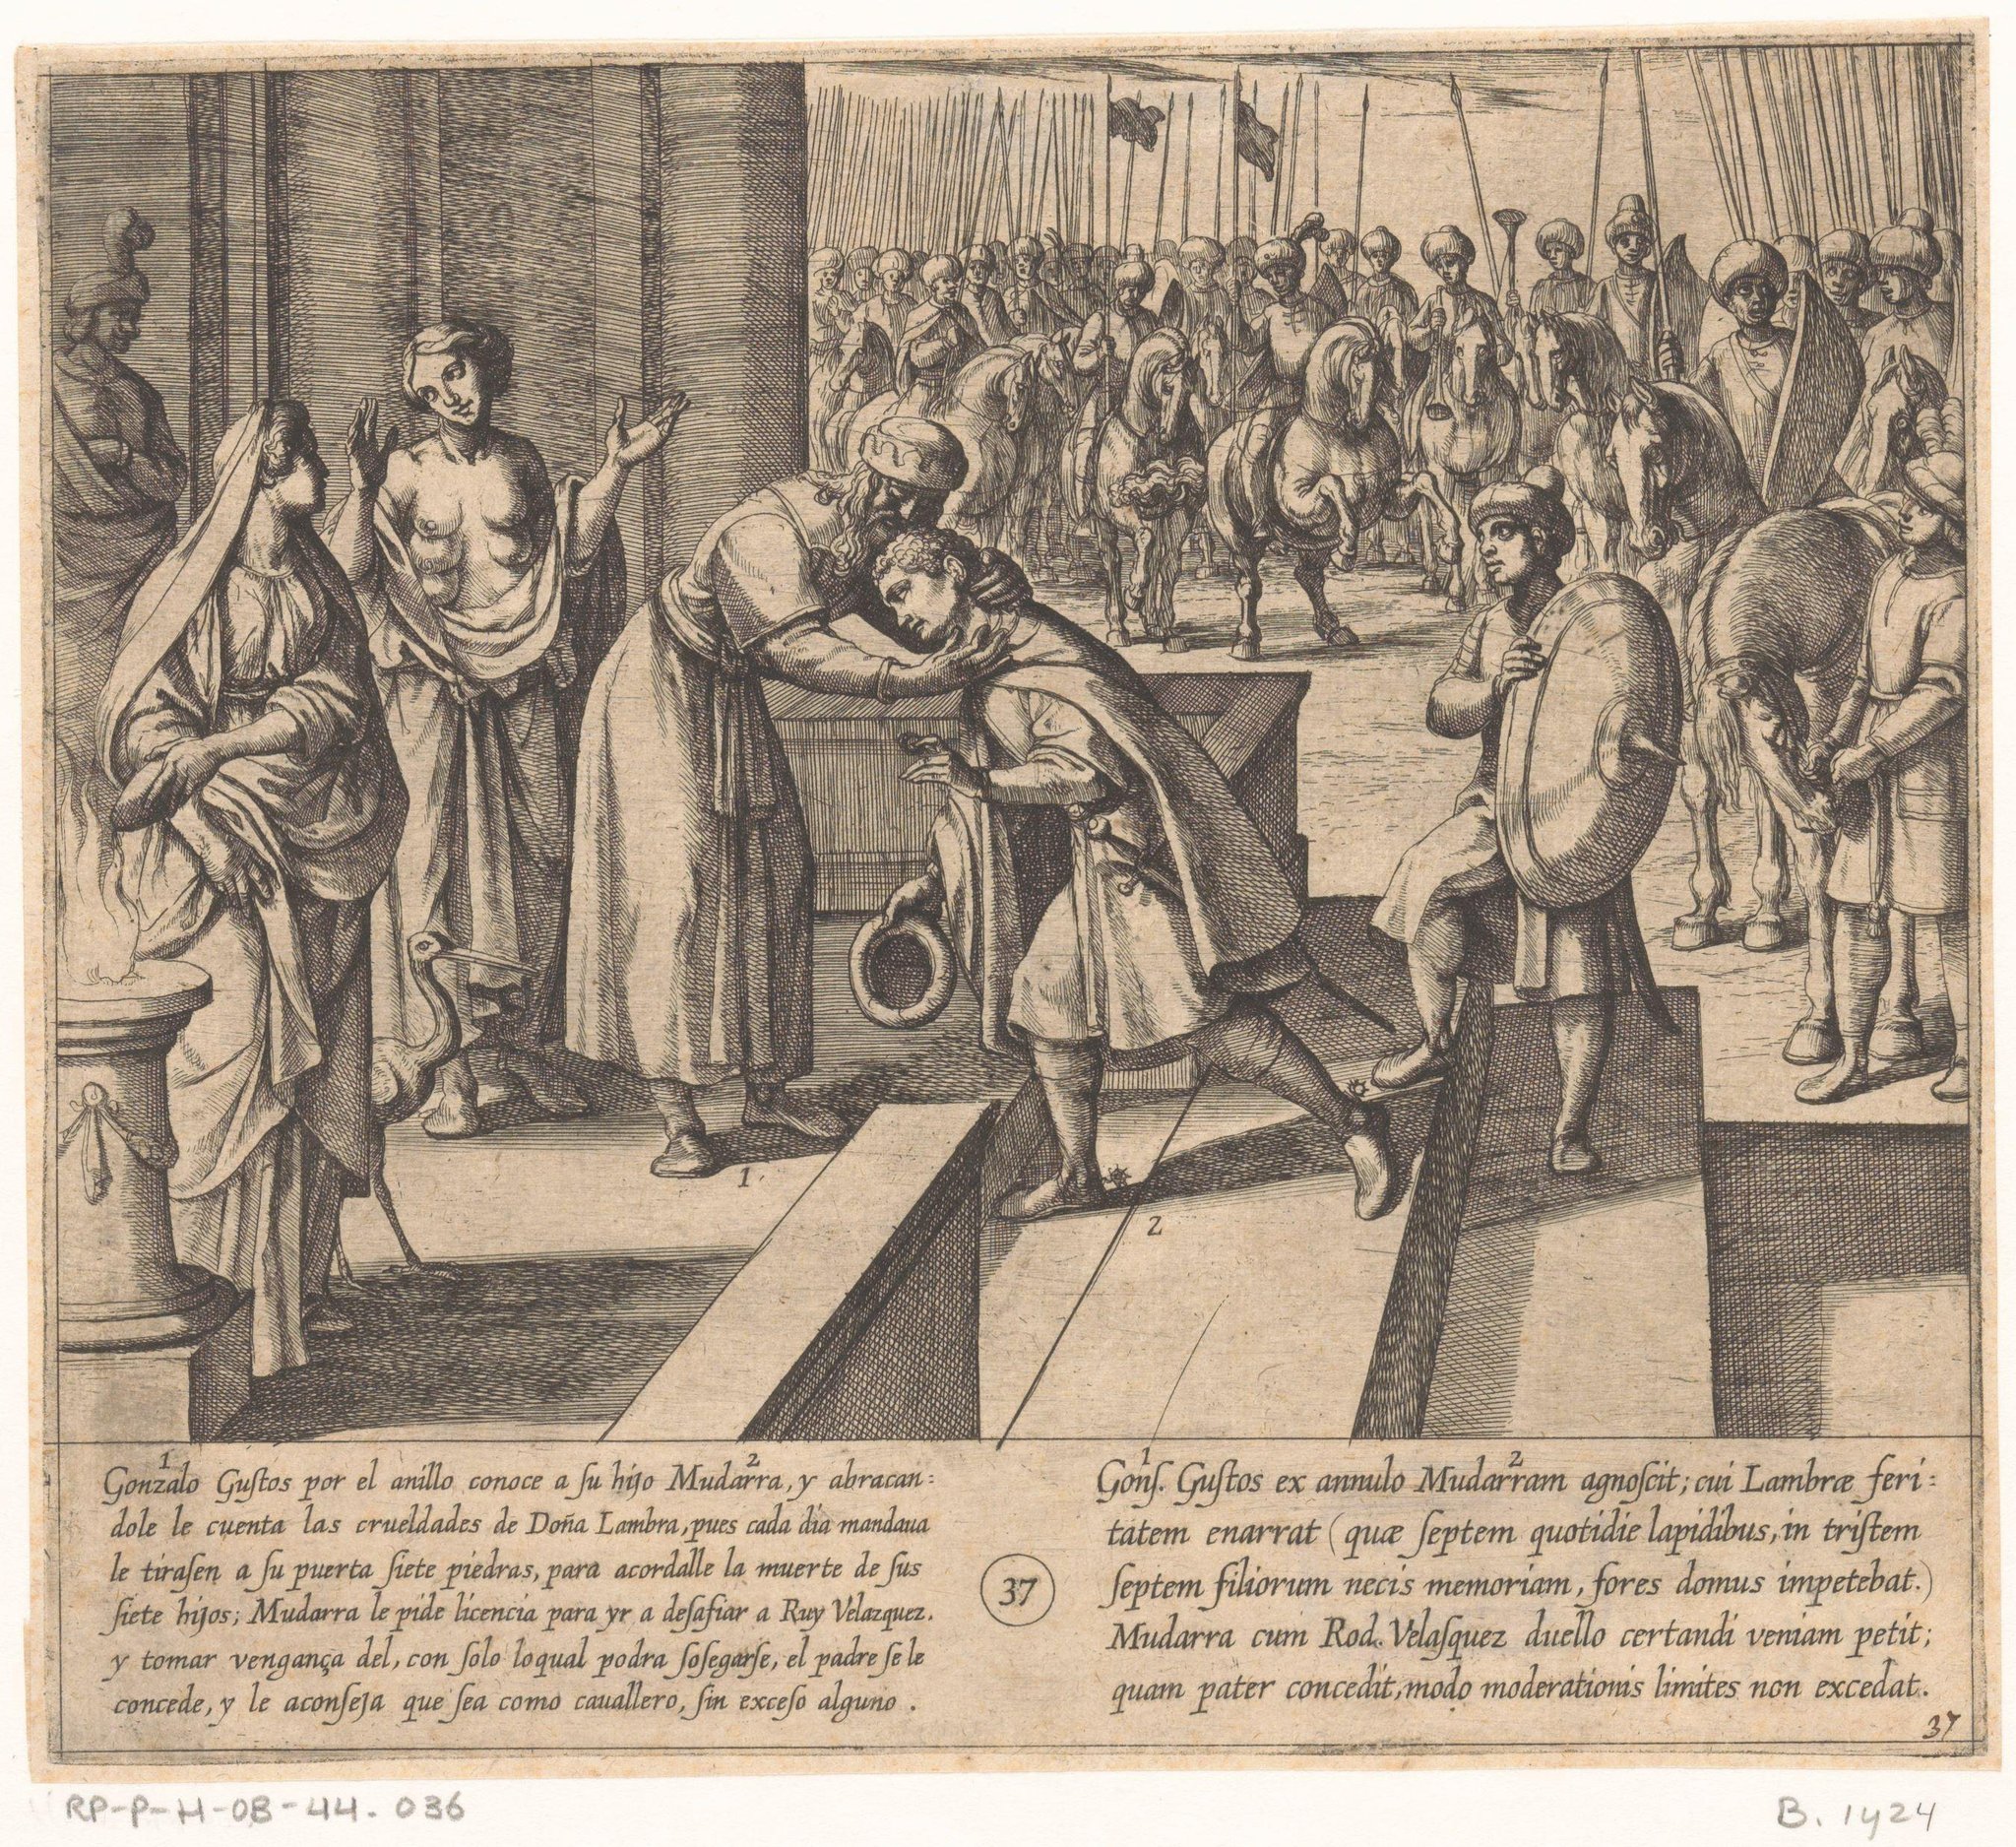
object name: print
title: Gonzalo Gustos herkent zijn zoon aan zijn ring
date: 1612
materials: paper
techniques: etching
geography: antwerp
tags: warfare; military affairs (+ cavalry, horsemen), tales and fairy tales, ring, recognizing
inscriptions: number: ‘37’, collector's mark: Lugt 11, collector's mark: ‘Hinloopen’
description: Deze prent maakt deel uit van een reeks van 40 prenten (+ titelprent) met voorstellingen uit het volksverhaal over de zeven infanten van Lara.